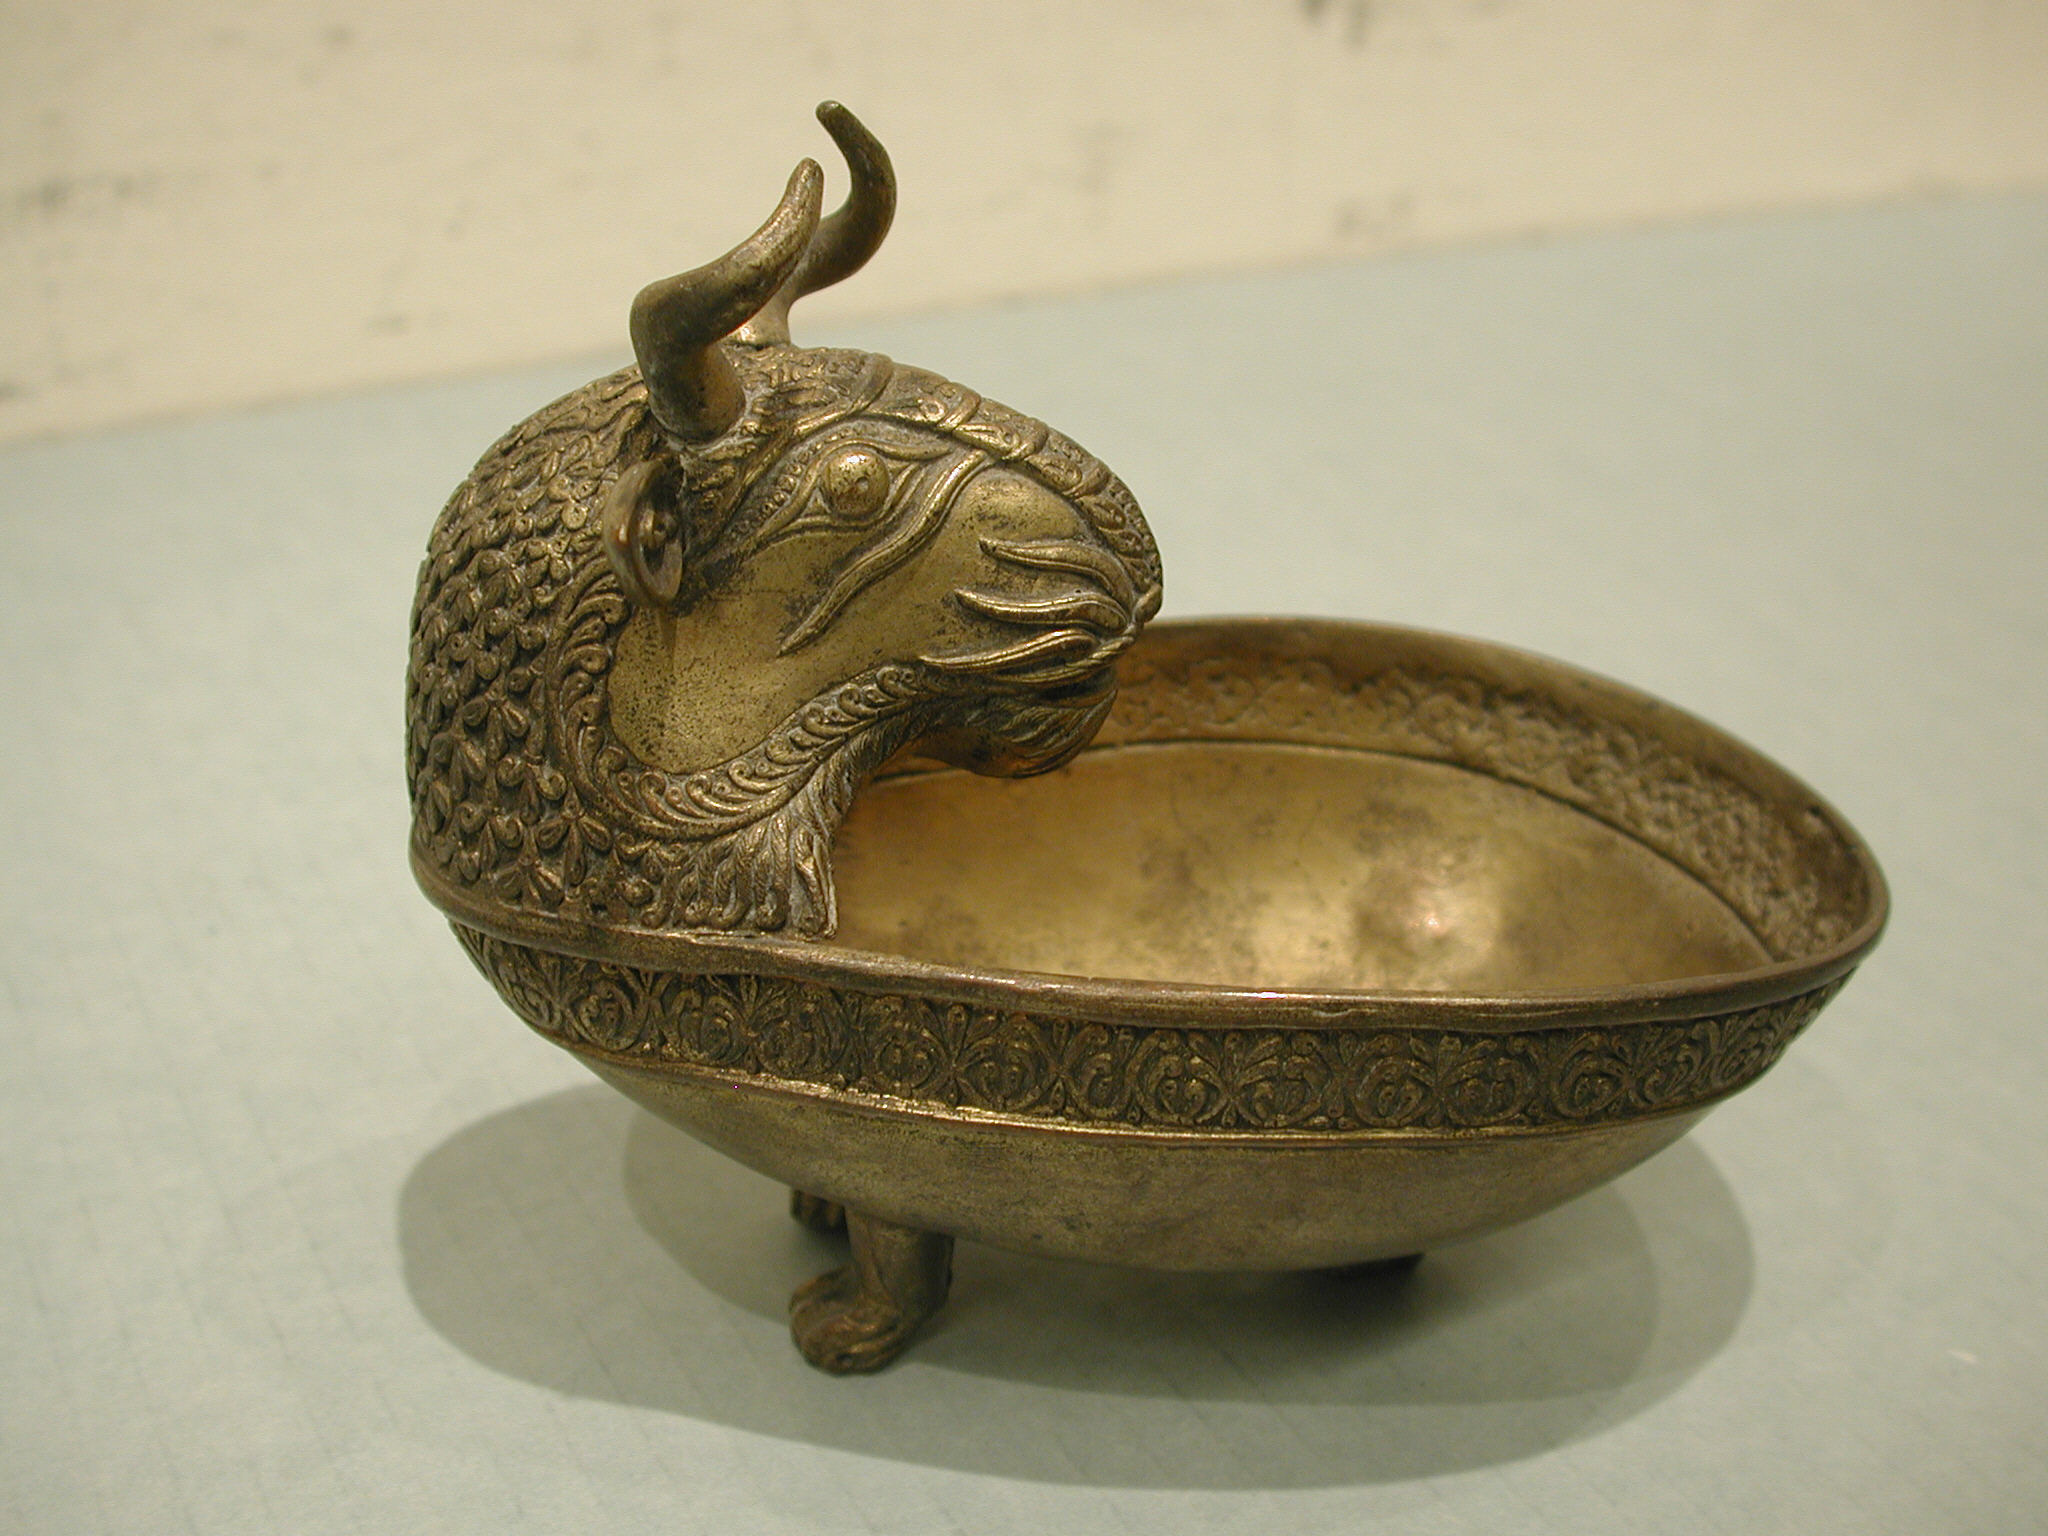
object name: bowl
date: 1801-1900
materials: metal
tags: animals